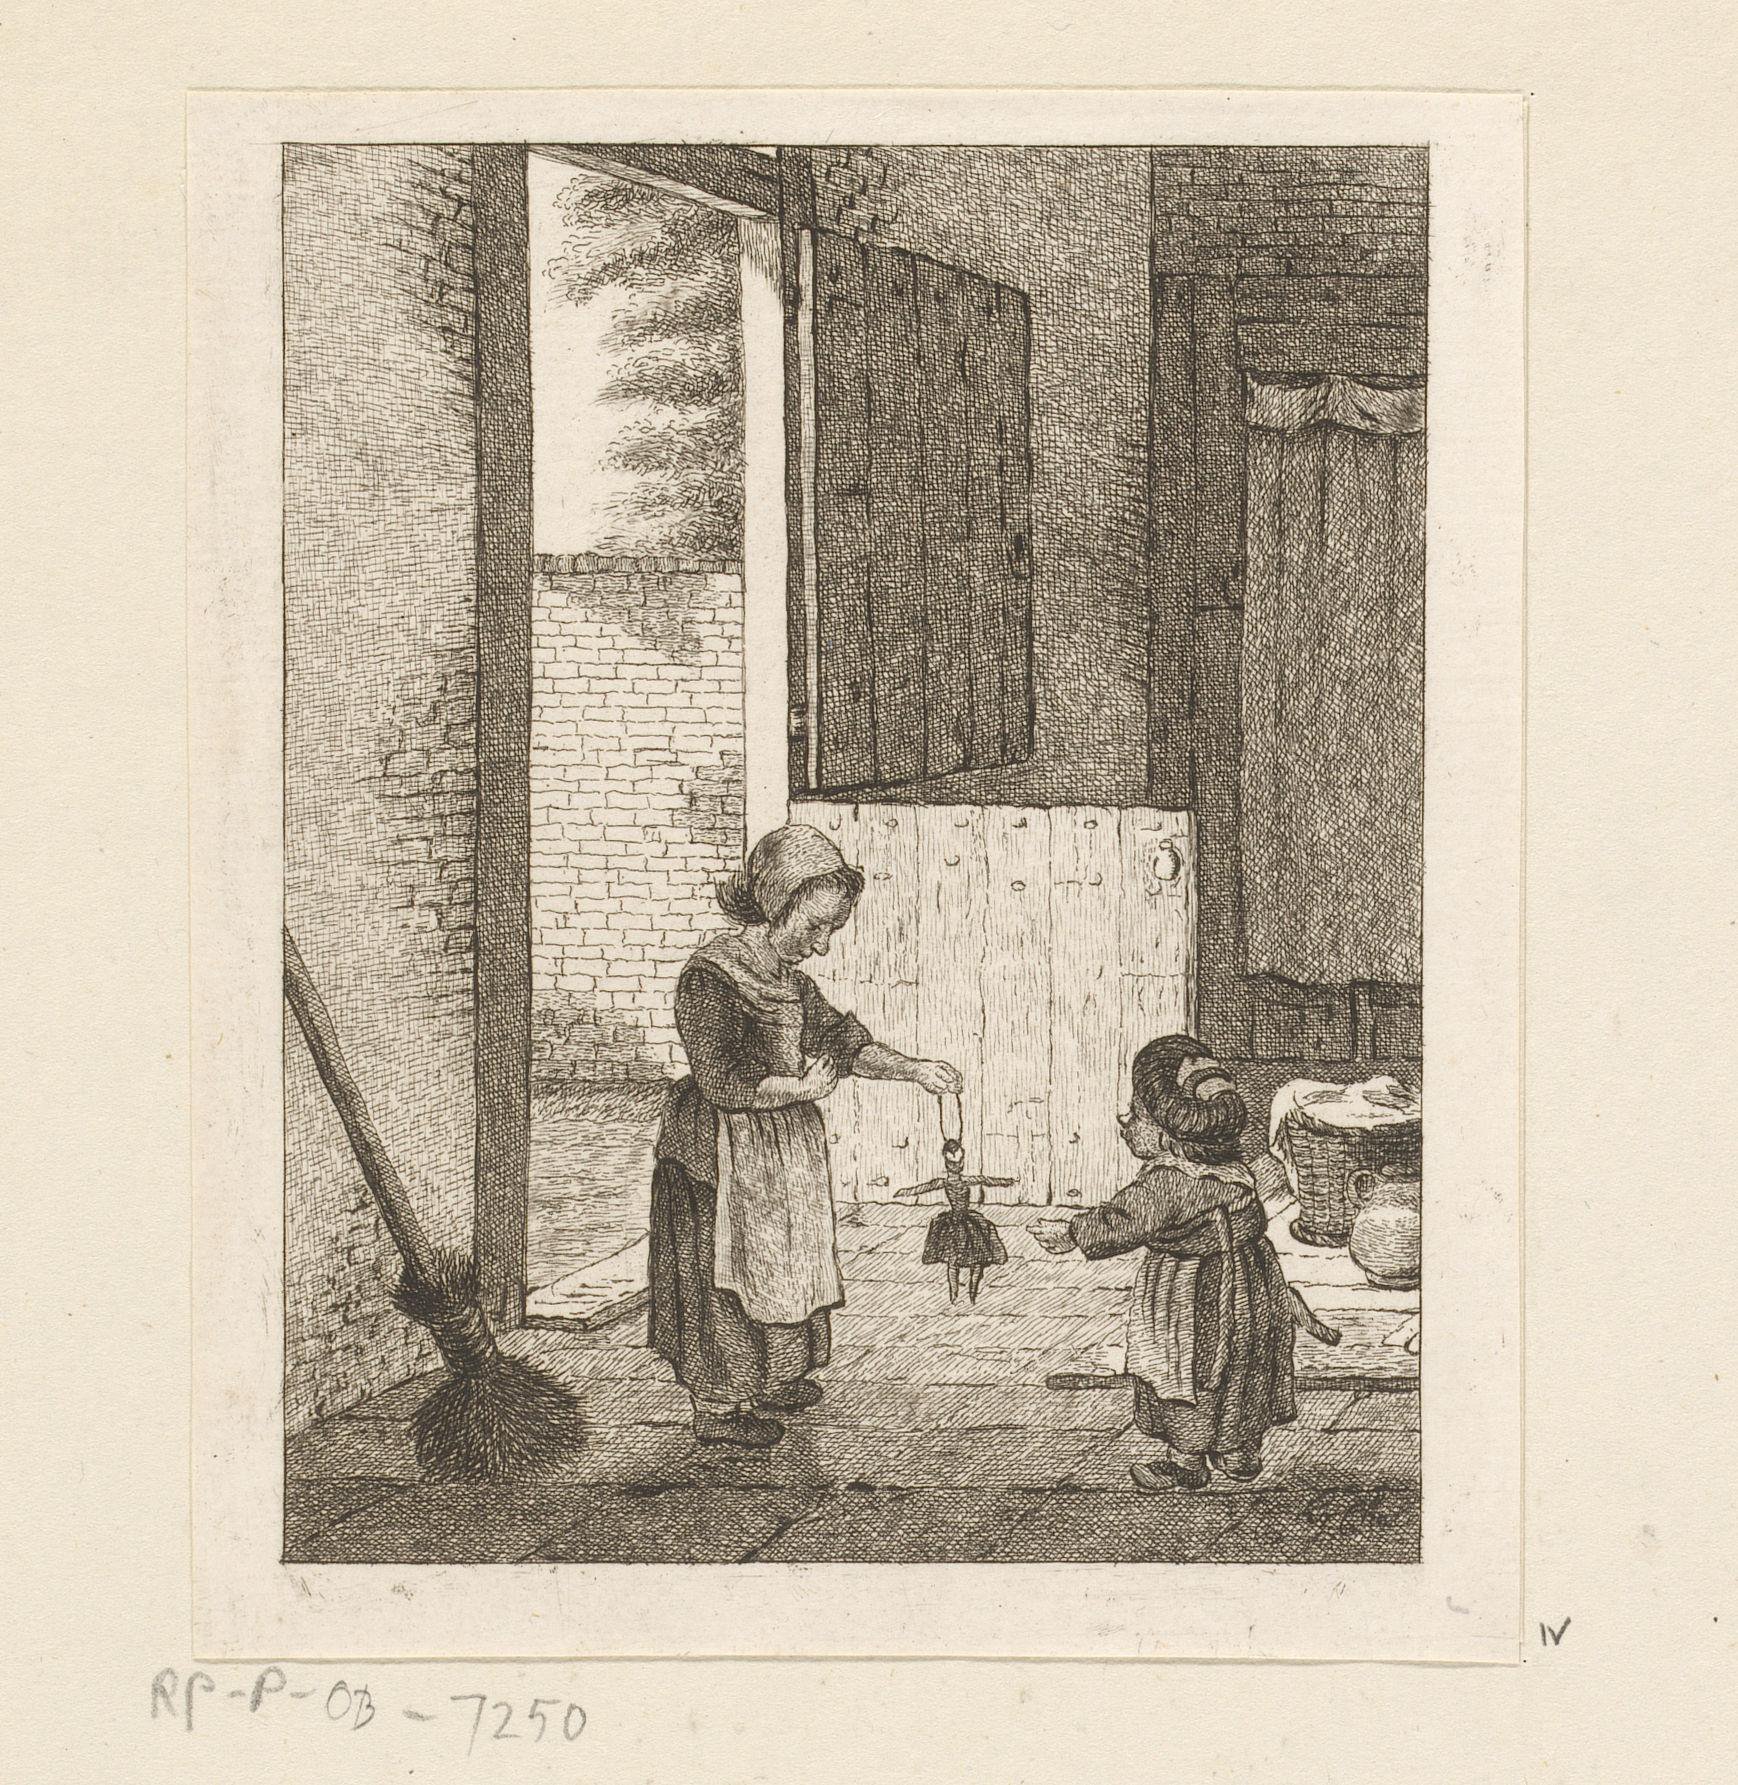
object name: print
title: Twee meisjes spelend met een pop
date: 1779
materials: paper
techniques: etching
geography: leiden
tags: kitchen-interior, (playing with) dolls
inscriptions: collector's mark: Lugt 2228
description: Twee meisjes spelen met een pop in de keuken. Een deur naar de buitenplaats staat open. Op de grond een mand wasgoed en tegen de muur een bezem.